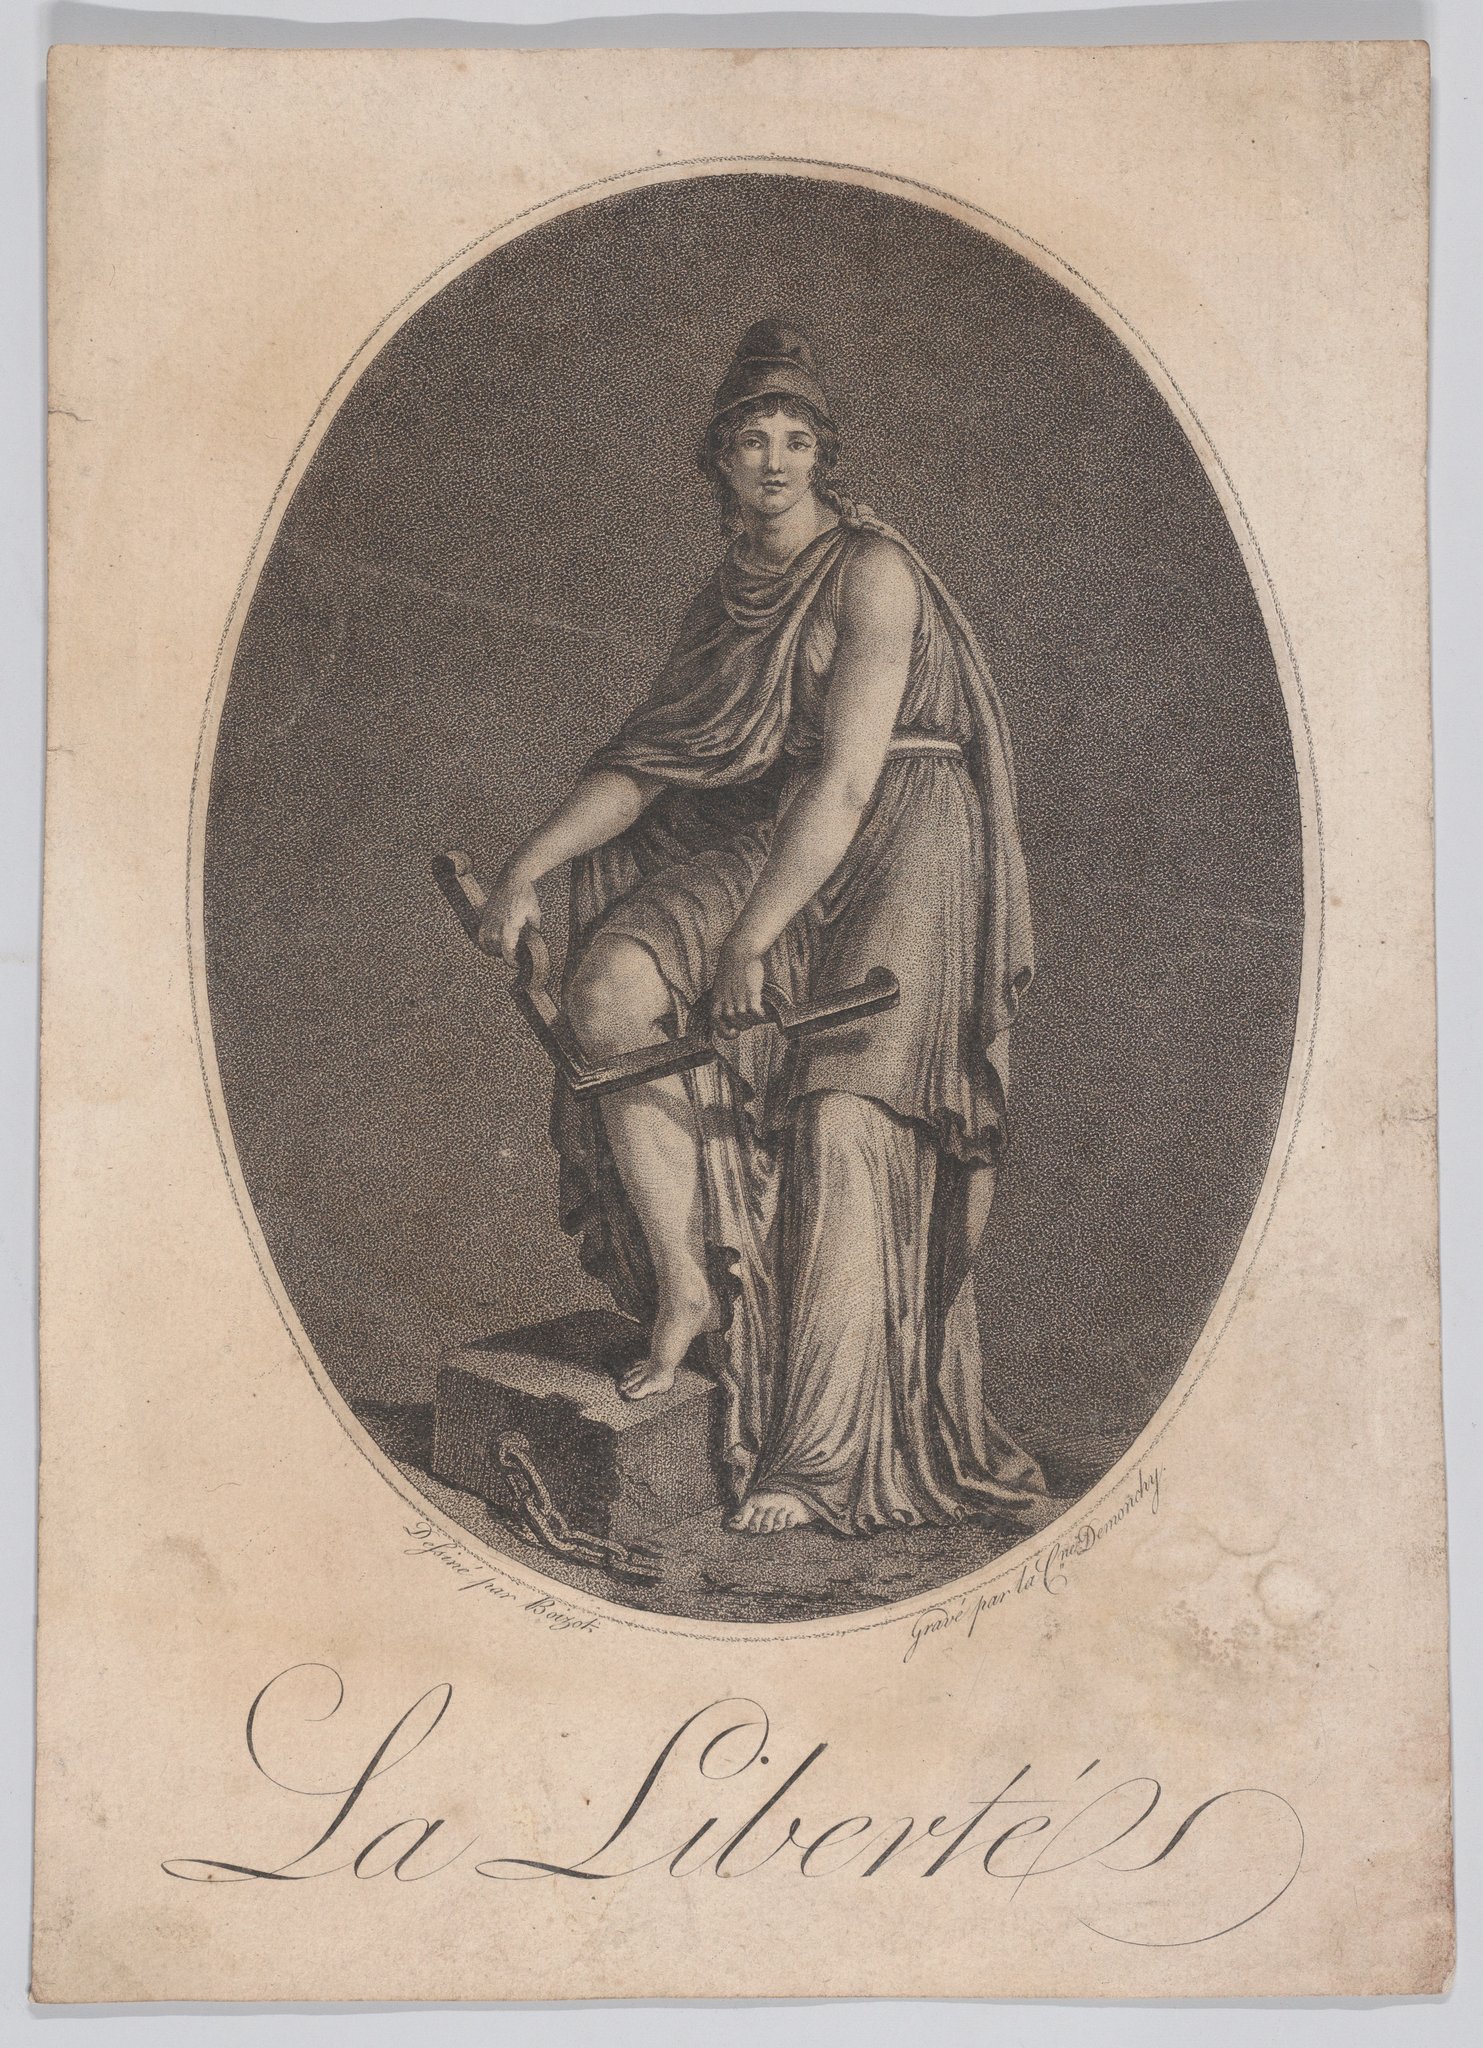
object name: print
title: La Liberté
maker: citoyenne de monchy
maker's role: artist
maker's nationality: french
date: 1794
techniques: etching